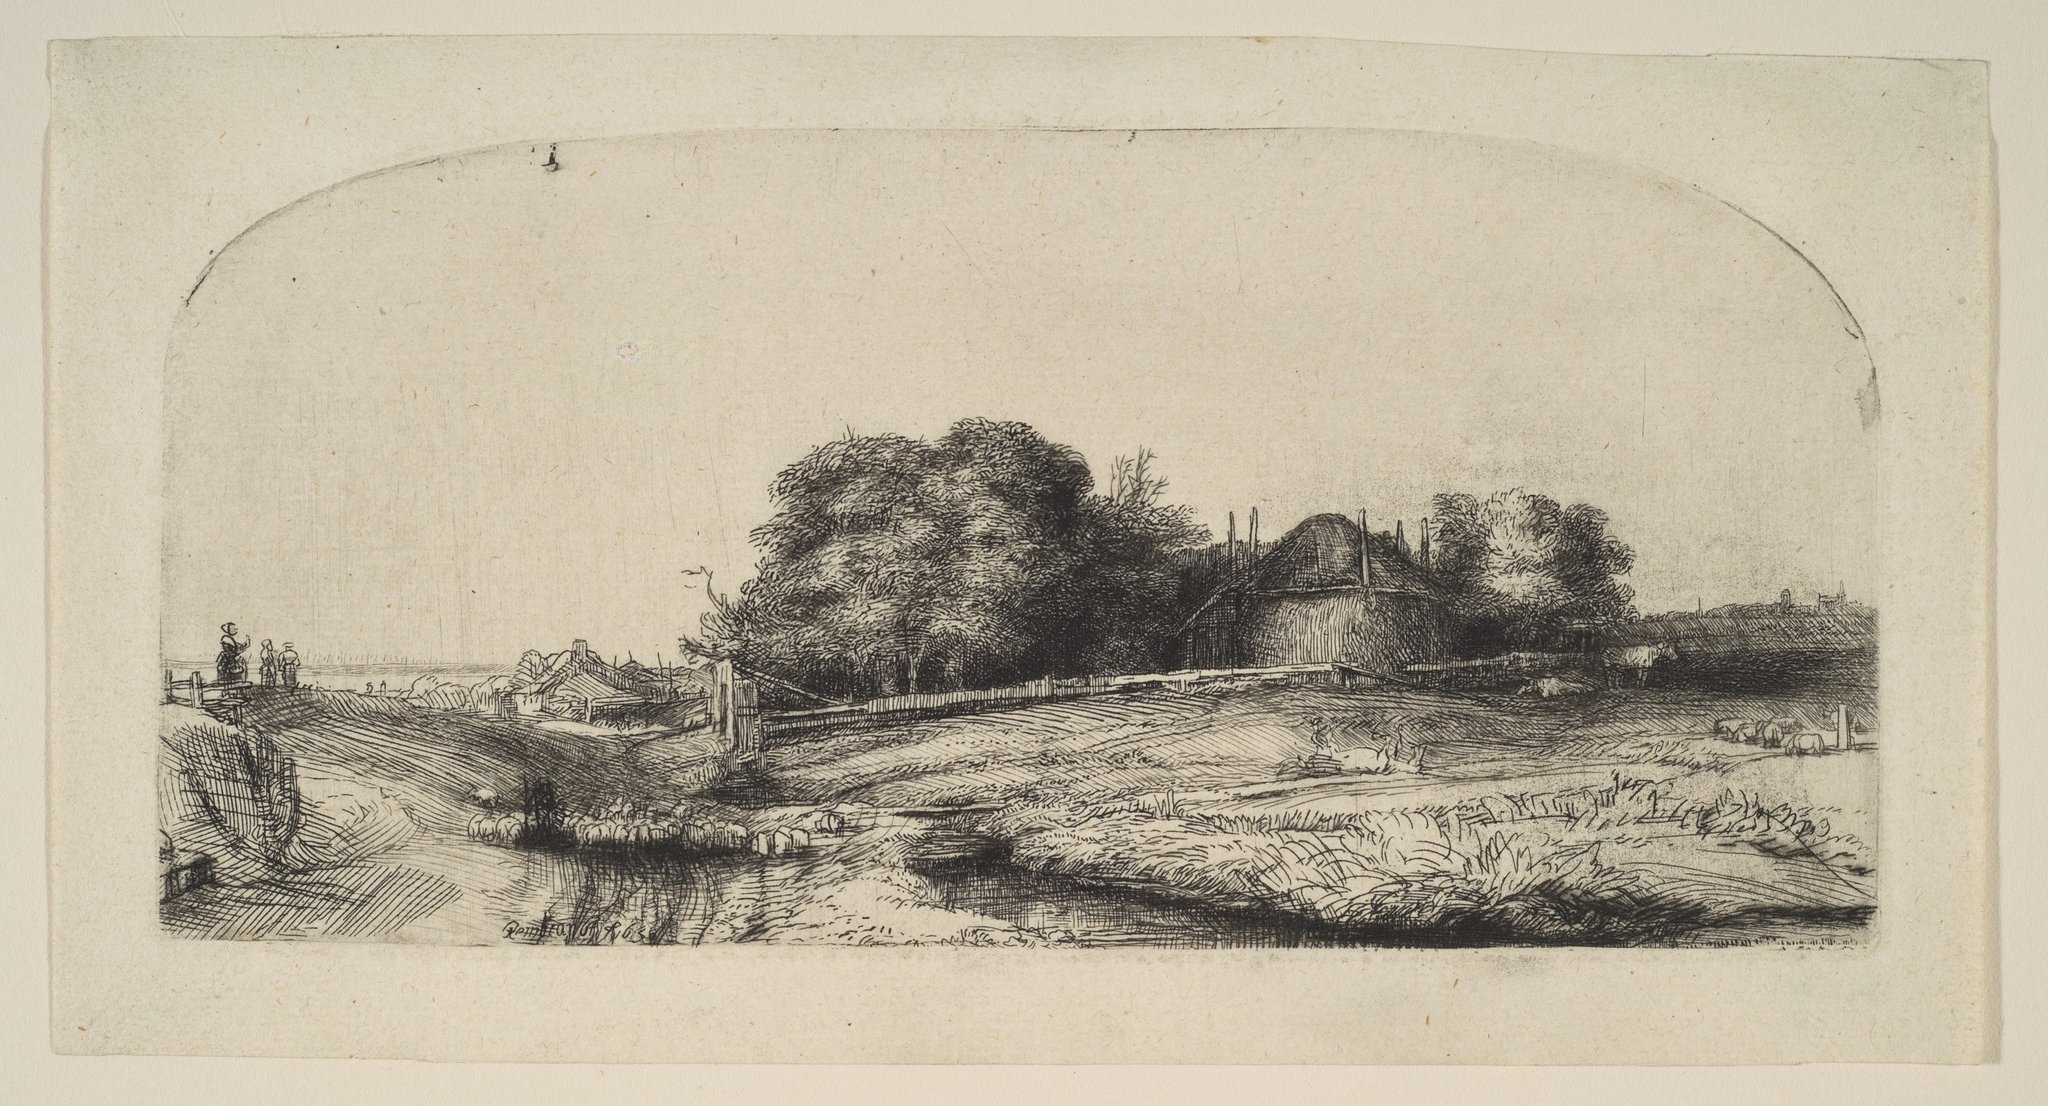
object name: print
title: Landscape with a Hay Barn and a Flock of Sheep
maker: rembrandt van rijn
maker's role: artist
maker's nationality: dutch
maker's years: 1606-1669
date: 1652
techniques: drypoint, etching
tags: barns,landscapes